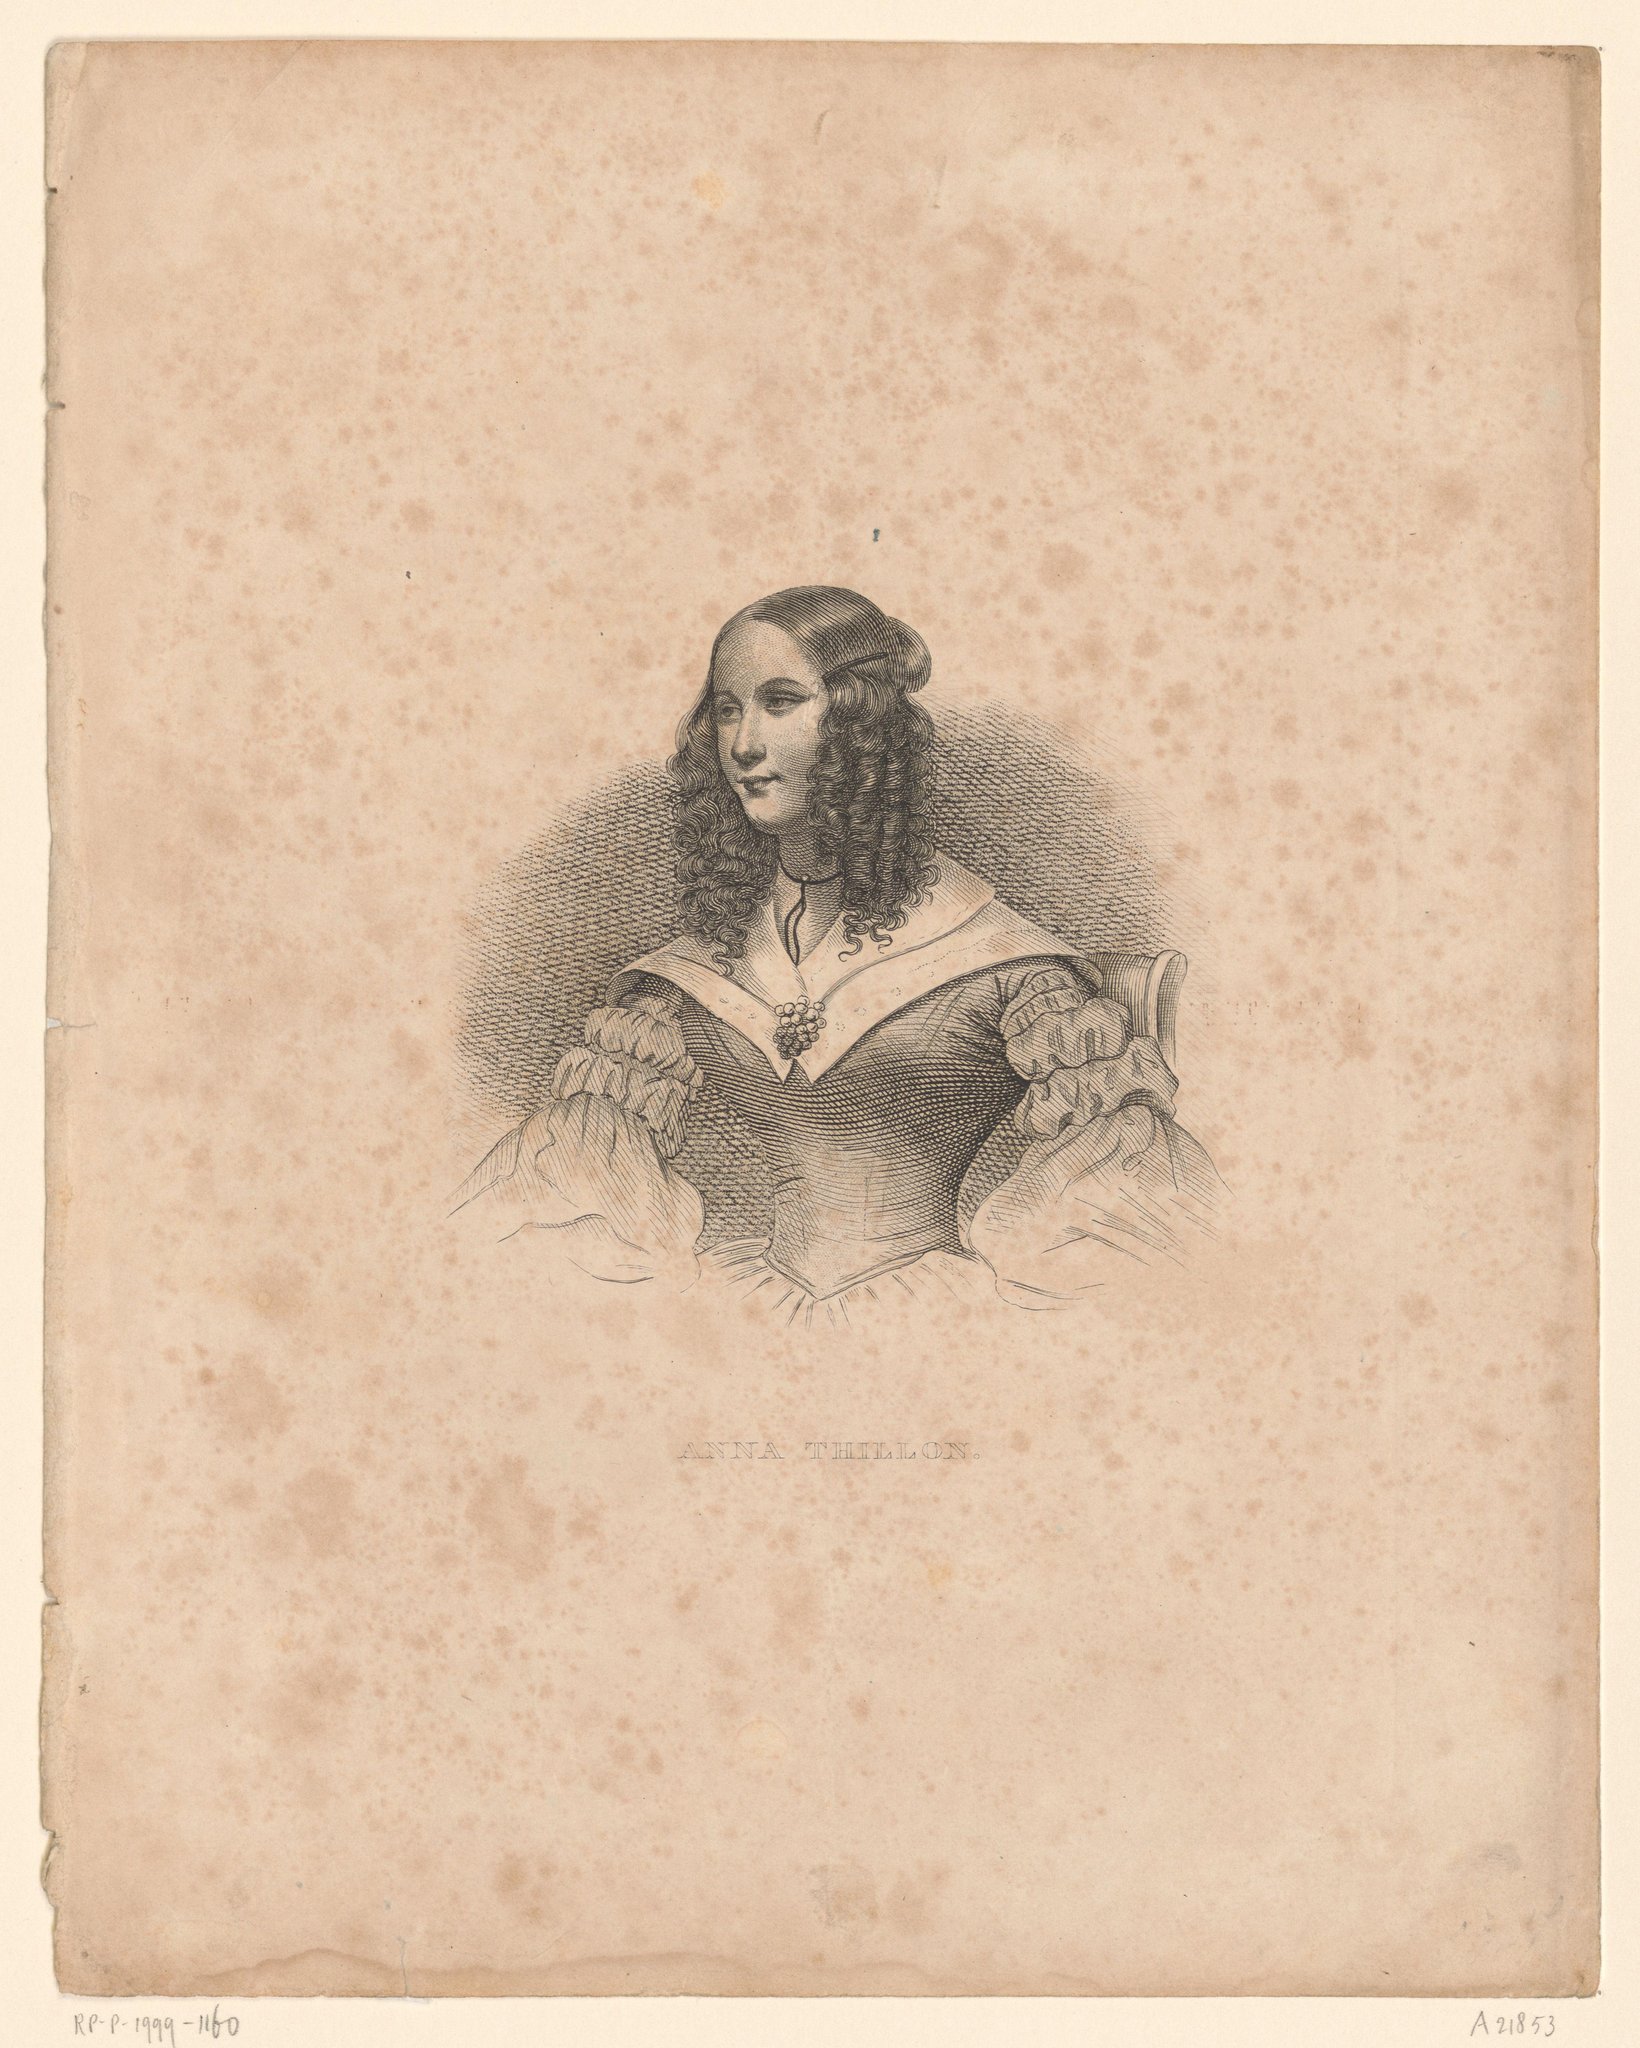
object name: print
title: Portret van Anna Thillon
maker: richter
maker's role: print maker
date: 1840-1880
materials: paper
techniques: engraving, etching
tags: historical persons - bb - woman, female singer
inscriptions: collector's mark: Lugt 2228, collector's mark: Lugt 2760